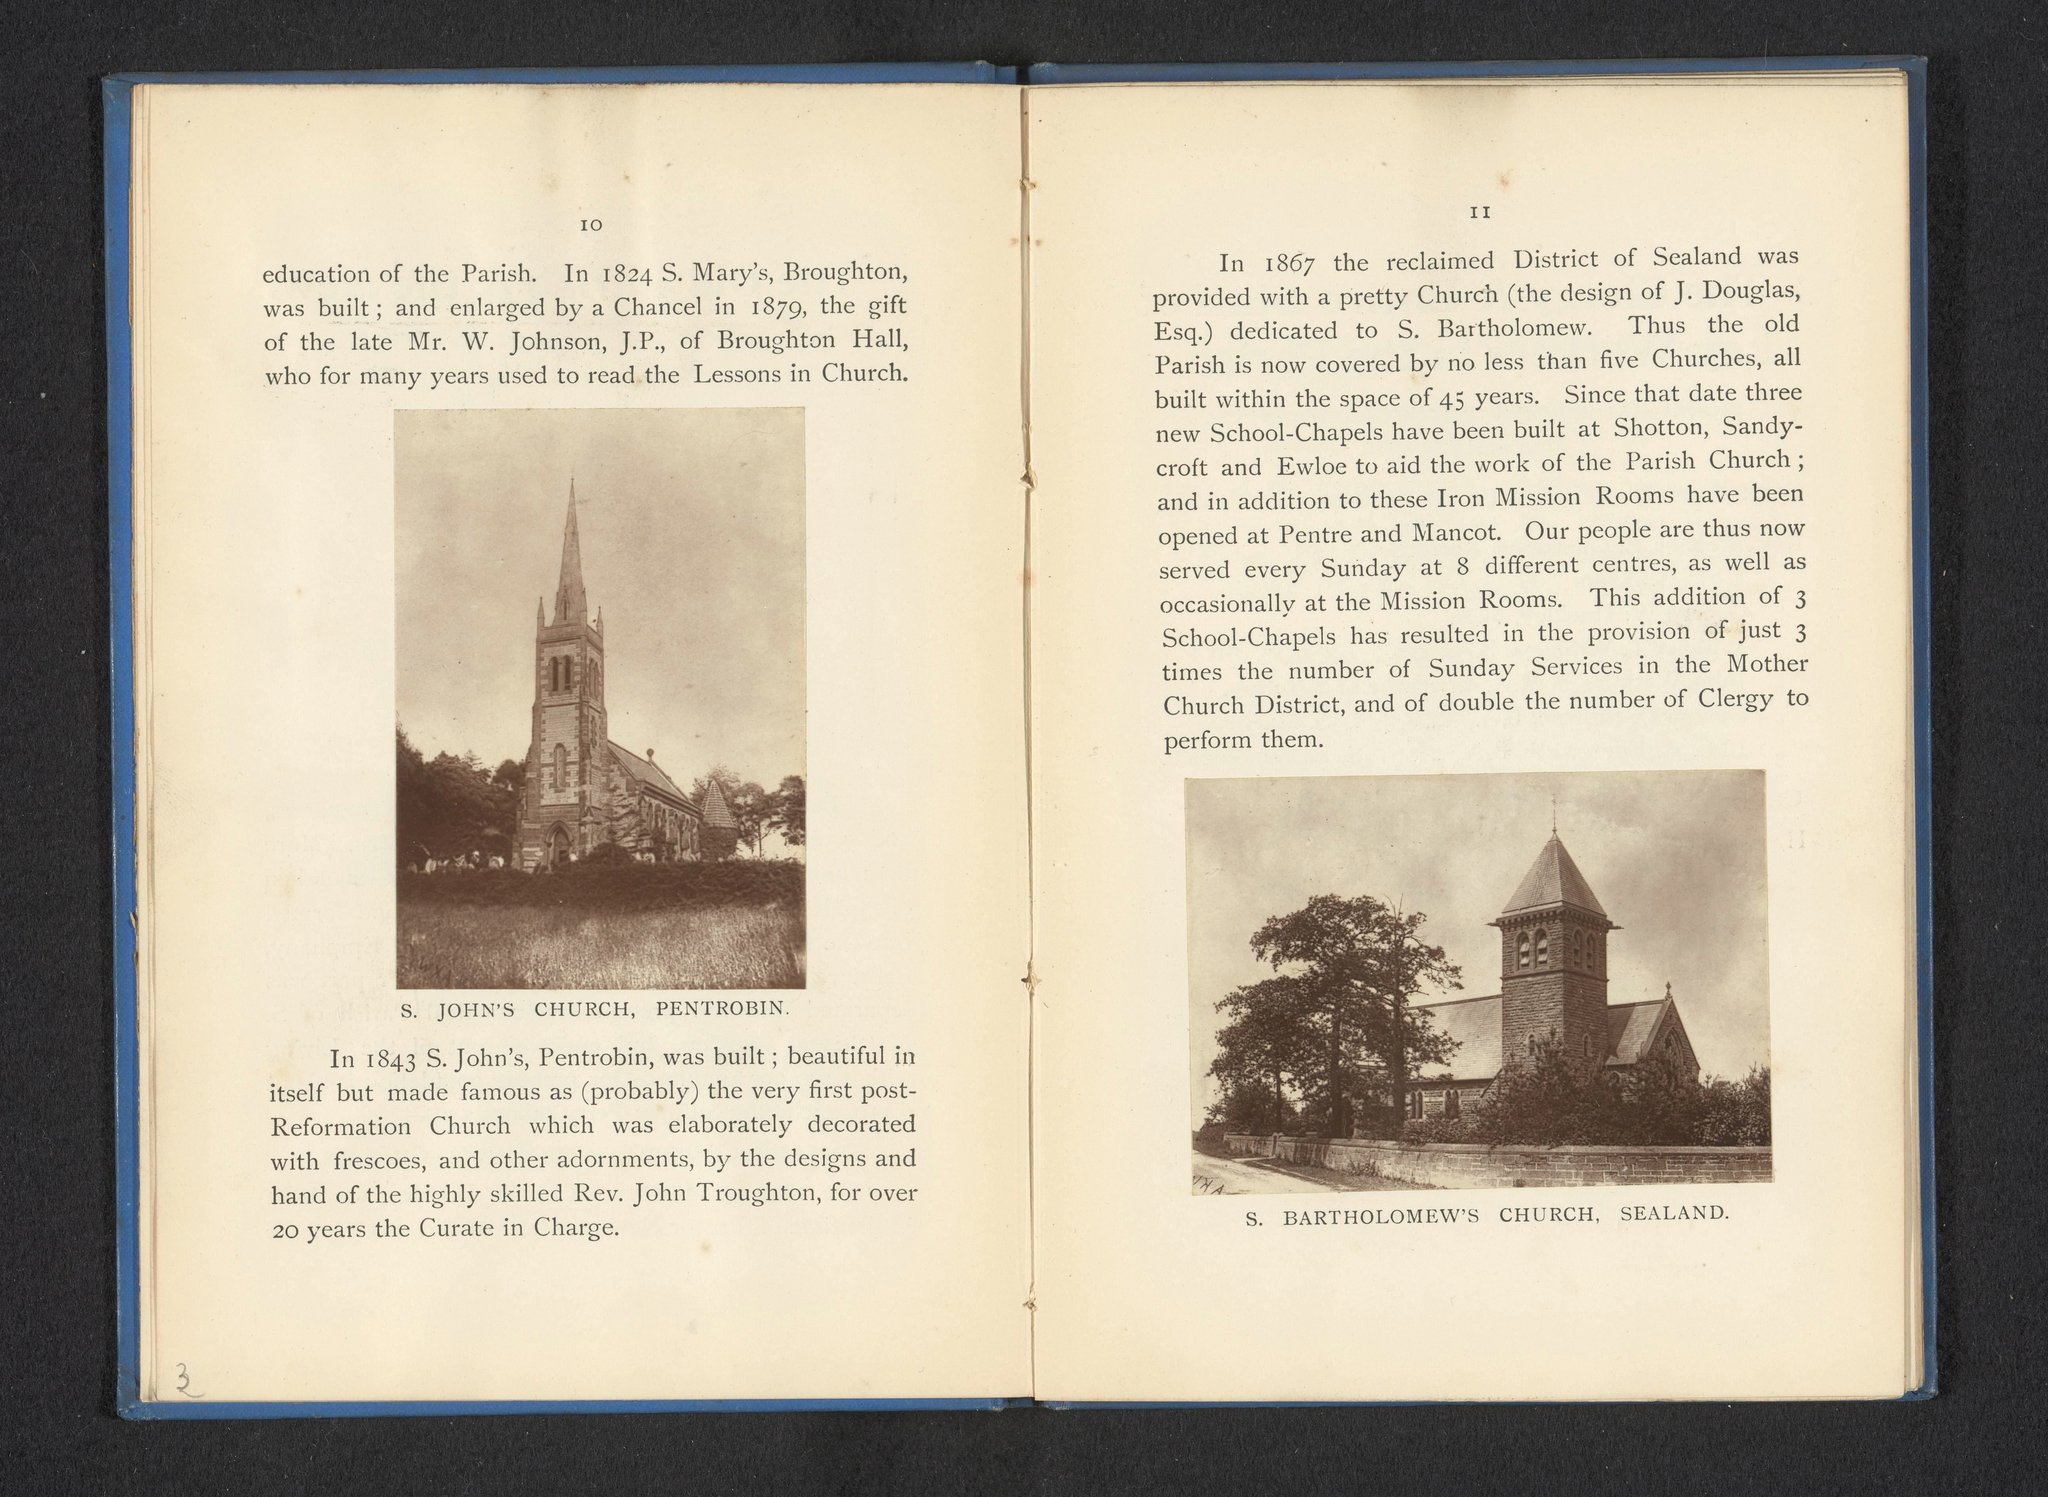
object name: photomechanical print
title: S. John's Church, Pentrobin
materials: paper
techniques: woodburytype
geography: penymynydd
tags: church (exterior), façade (of house or building)